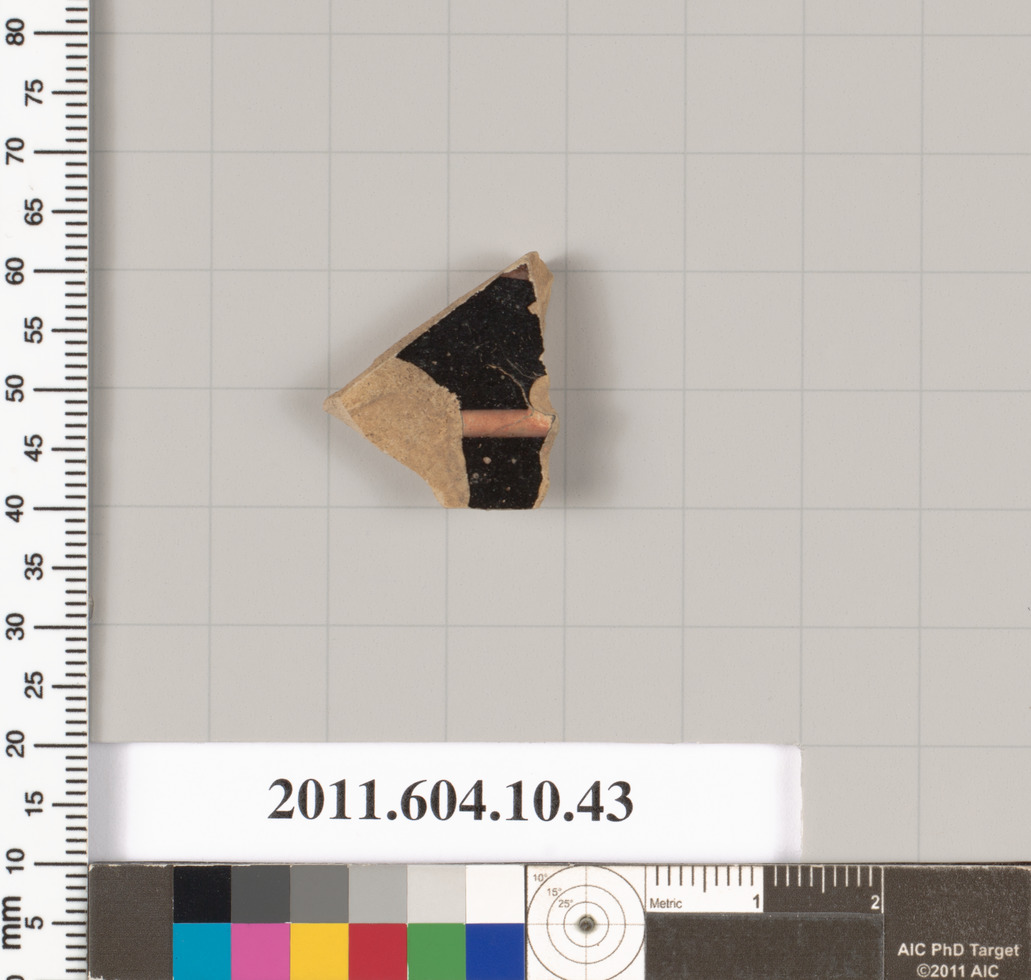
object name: kylix fragment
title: Terracotta fragment of a kylix (drinking cup)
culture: etruscan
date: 334-301 BCE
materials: terracotta